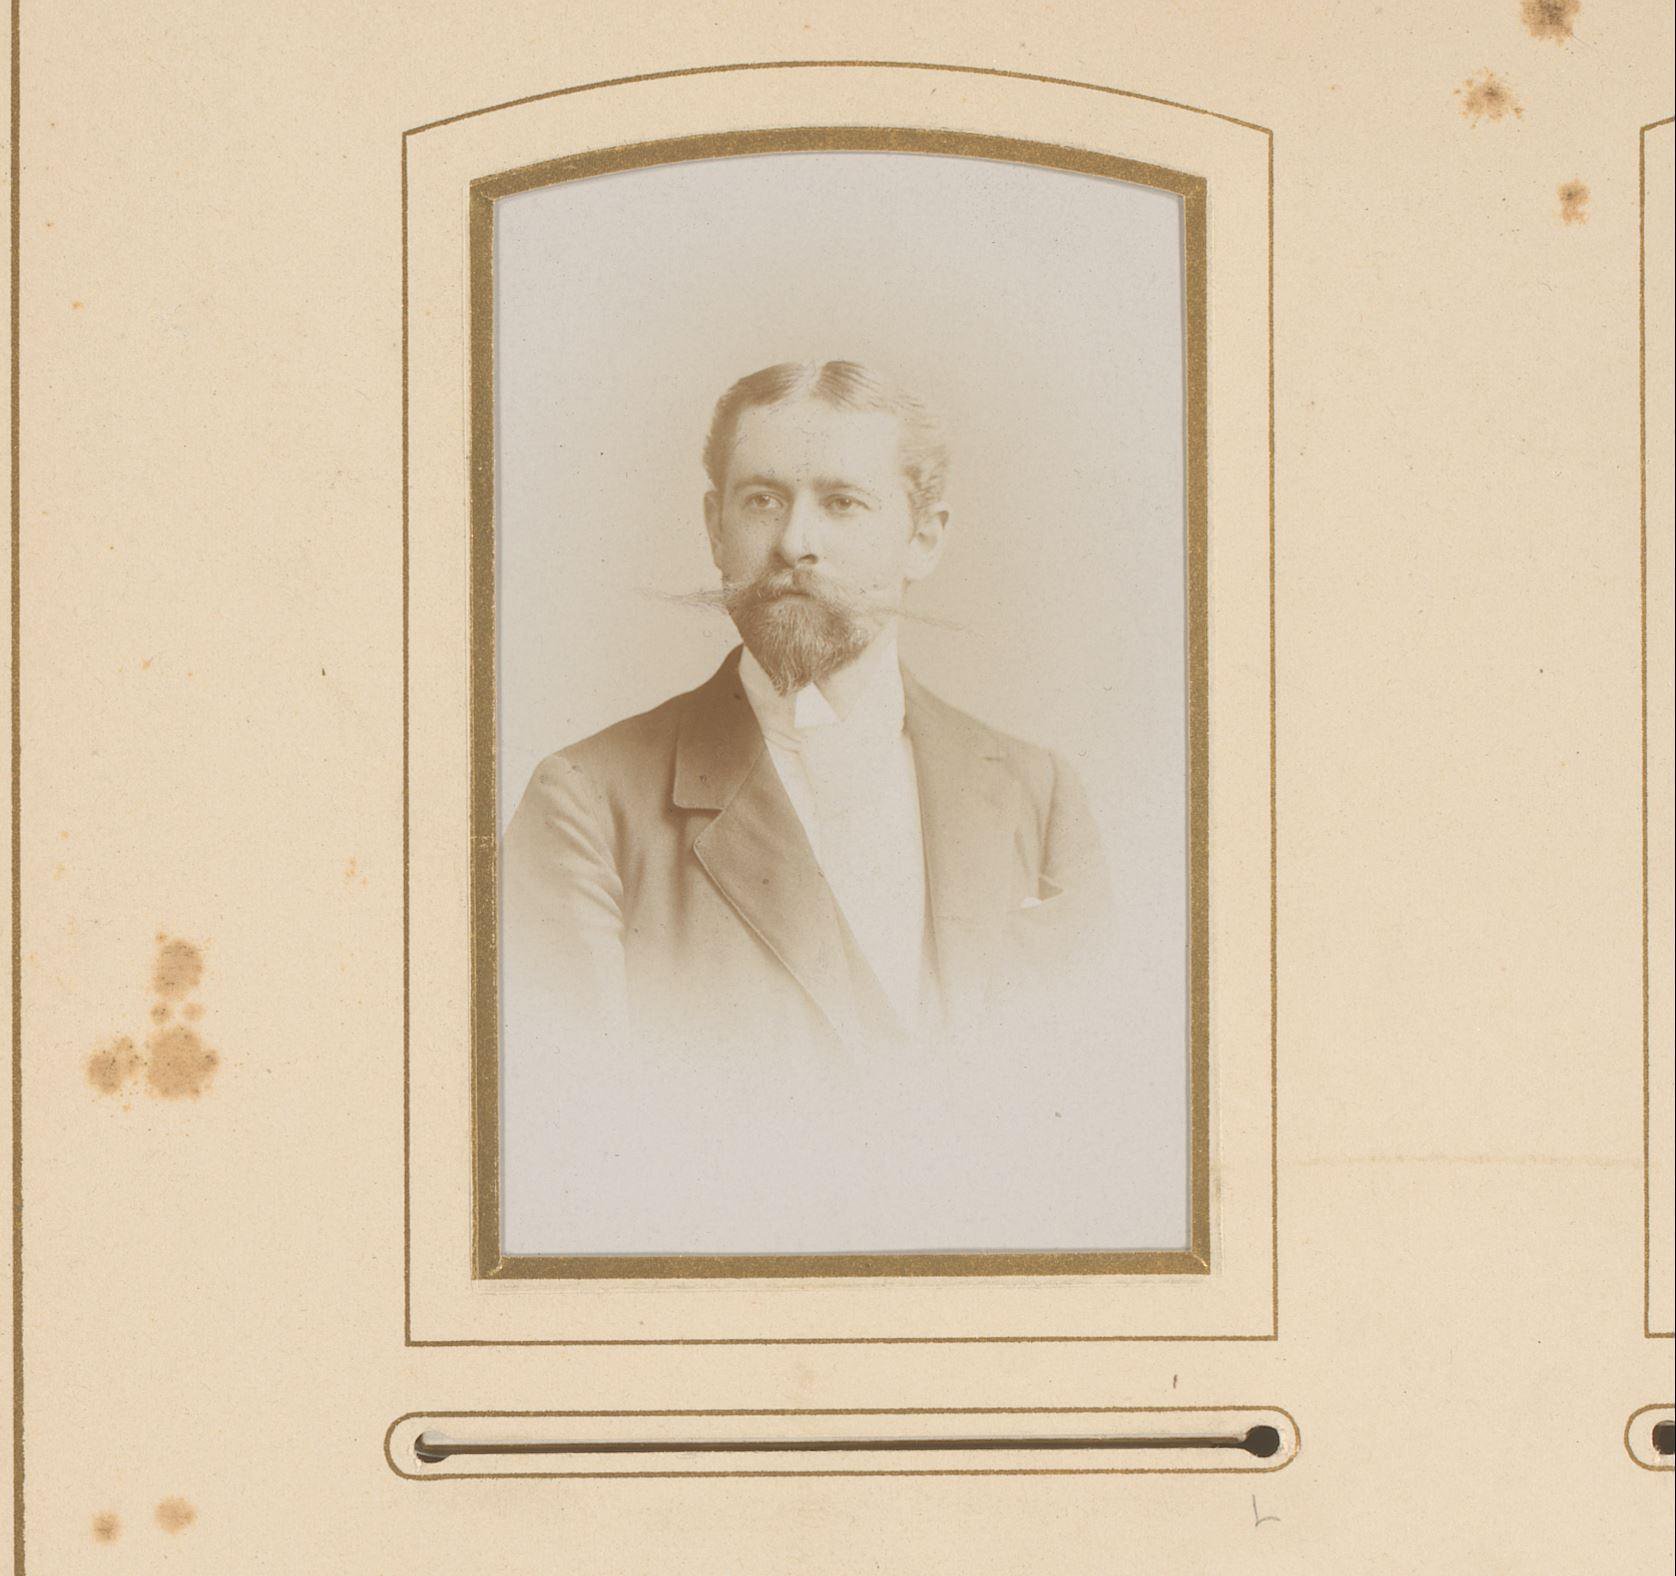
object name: album leaf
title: Portret van een man met snor en baard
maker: jacques pilartz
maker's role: fotograaf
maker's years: 1834-1910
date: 1880-1920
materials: cardboard, photographic support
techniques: collodion silver print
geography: bad kissingen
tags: moustache, historical persons, beard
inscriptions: inscription: ‘J. Pilartz/ Bad Kissingen/ K. u. K. Hof-Photograph/ Inhaber der Sachsen-Altenburg. Medaille für Kunst u. Wissenschaft/ mit der Krone, sowie der italienische gold. Medaille für Kunst u. Wissenschaft./ Silberne Medaille internationale Ausstellung Amsterdam 1868.’